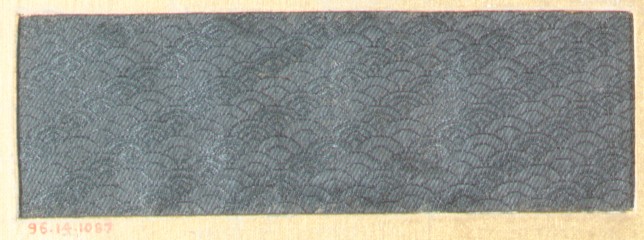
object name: piece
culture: japanese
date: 1701-1900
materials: silk